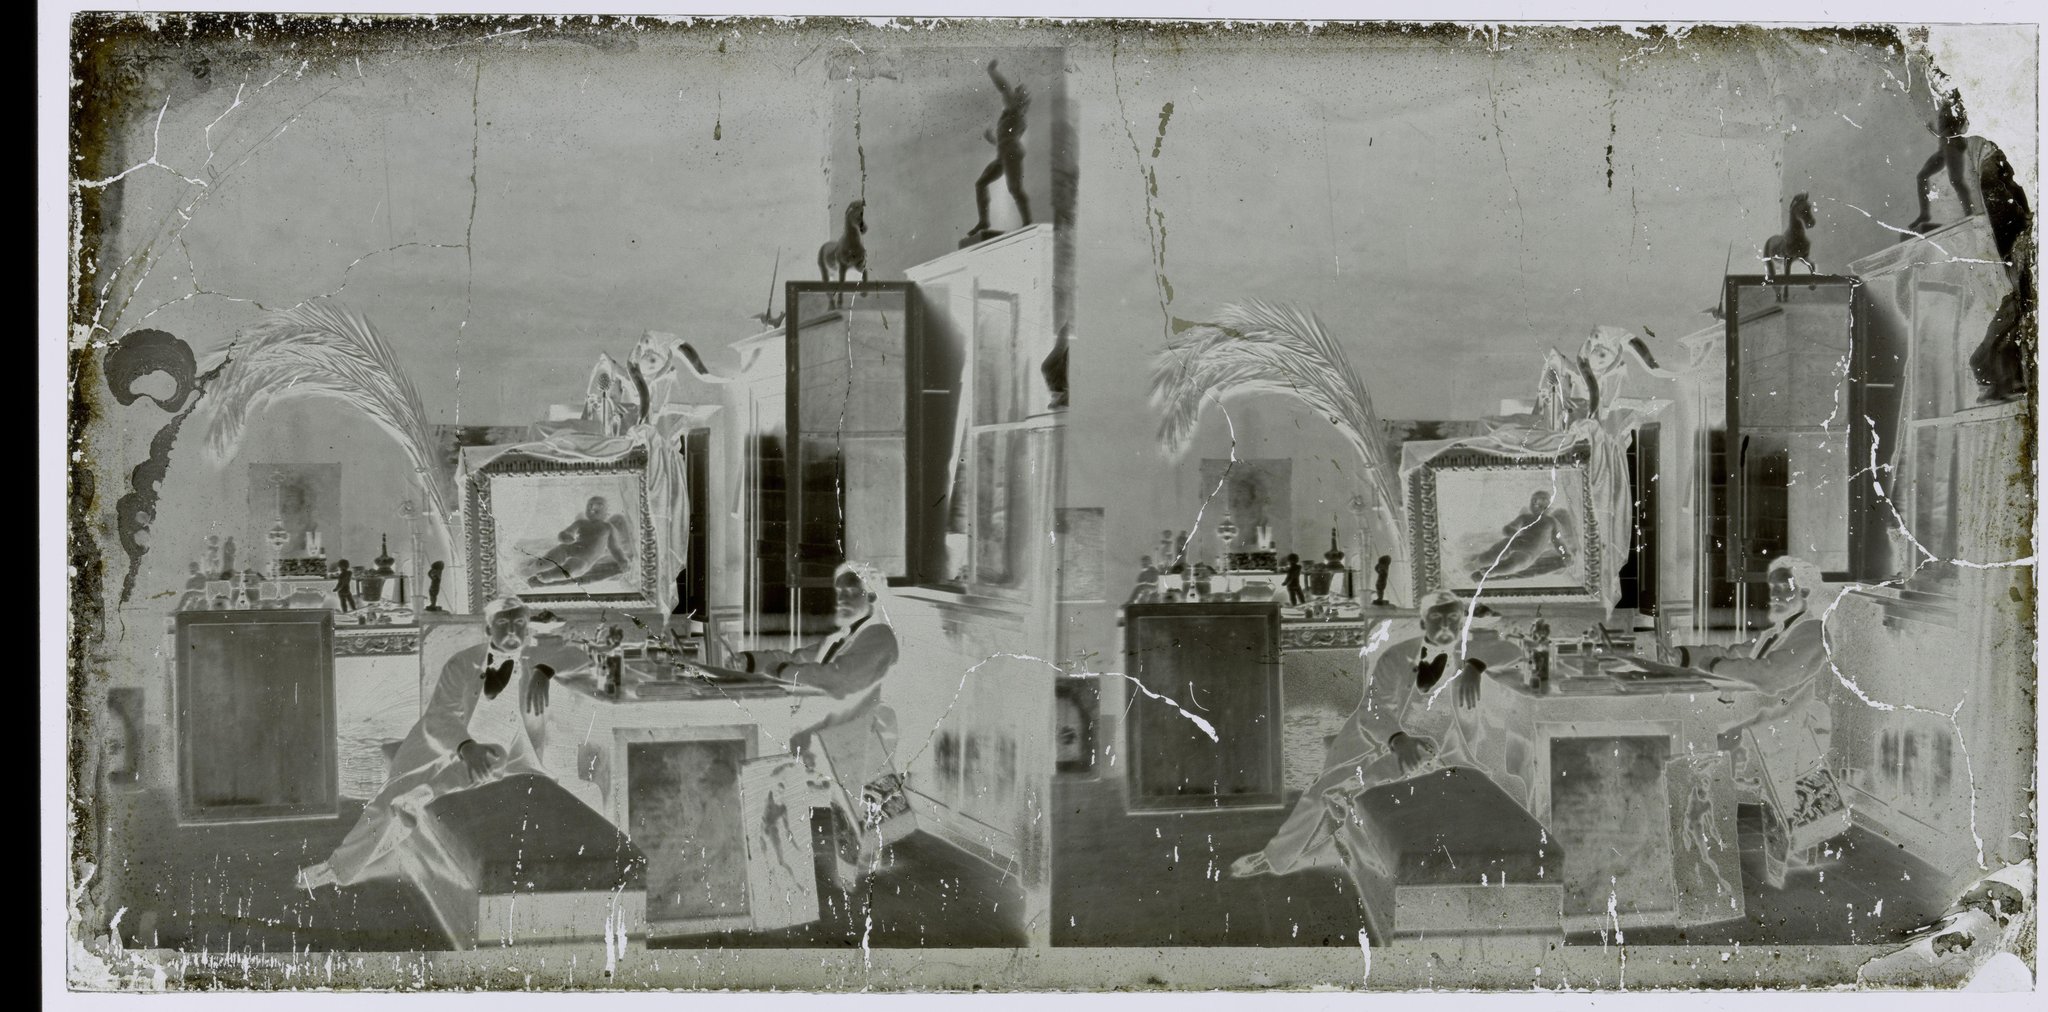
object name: glass negative stereograph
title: Laurens Lodewijk Kleijn in zijn atelier in Rome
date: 1860-1862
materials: glass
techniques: collodion process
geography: rome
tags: draughtsman, laurens lodewijk kleijn, workshop, studio of the artist (in general), rome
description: Onderdeel van een groep glasnegatieven uit de nalatenschap van de schilder Laurens Lodewijk Kleijn, met stillevens, portretten, zelfportretten en kunstreproducties.